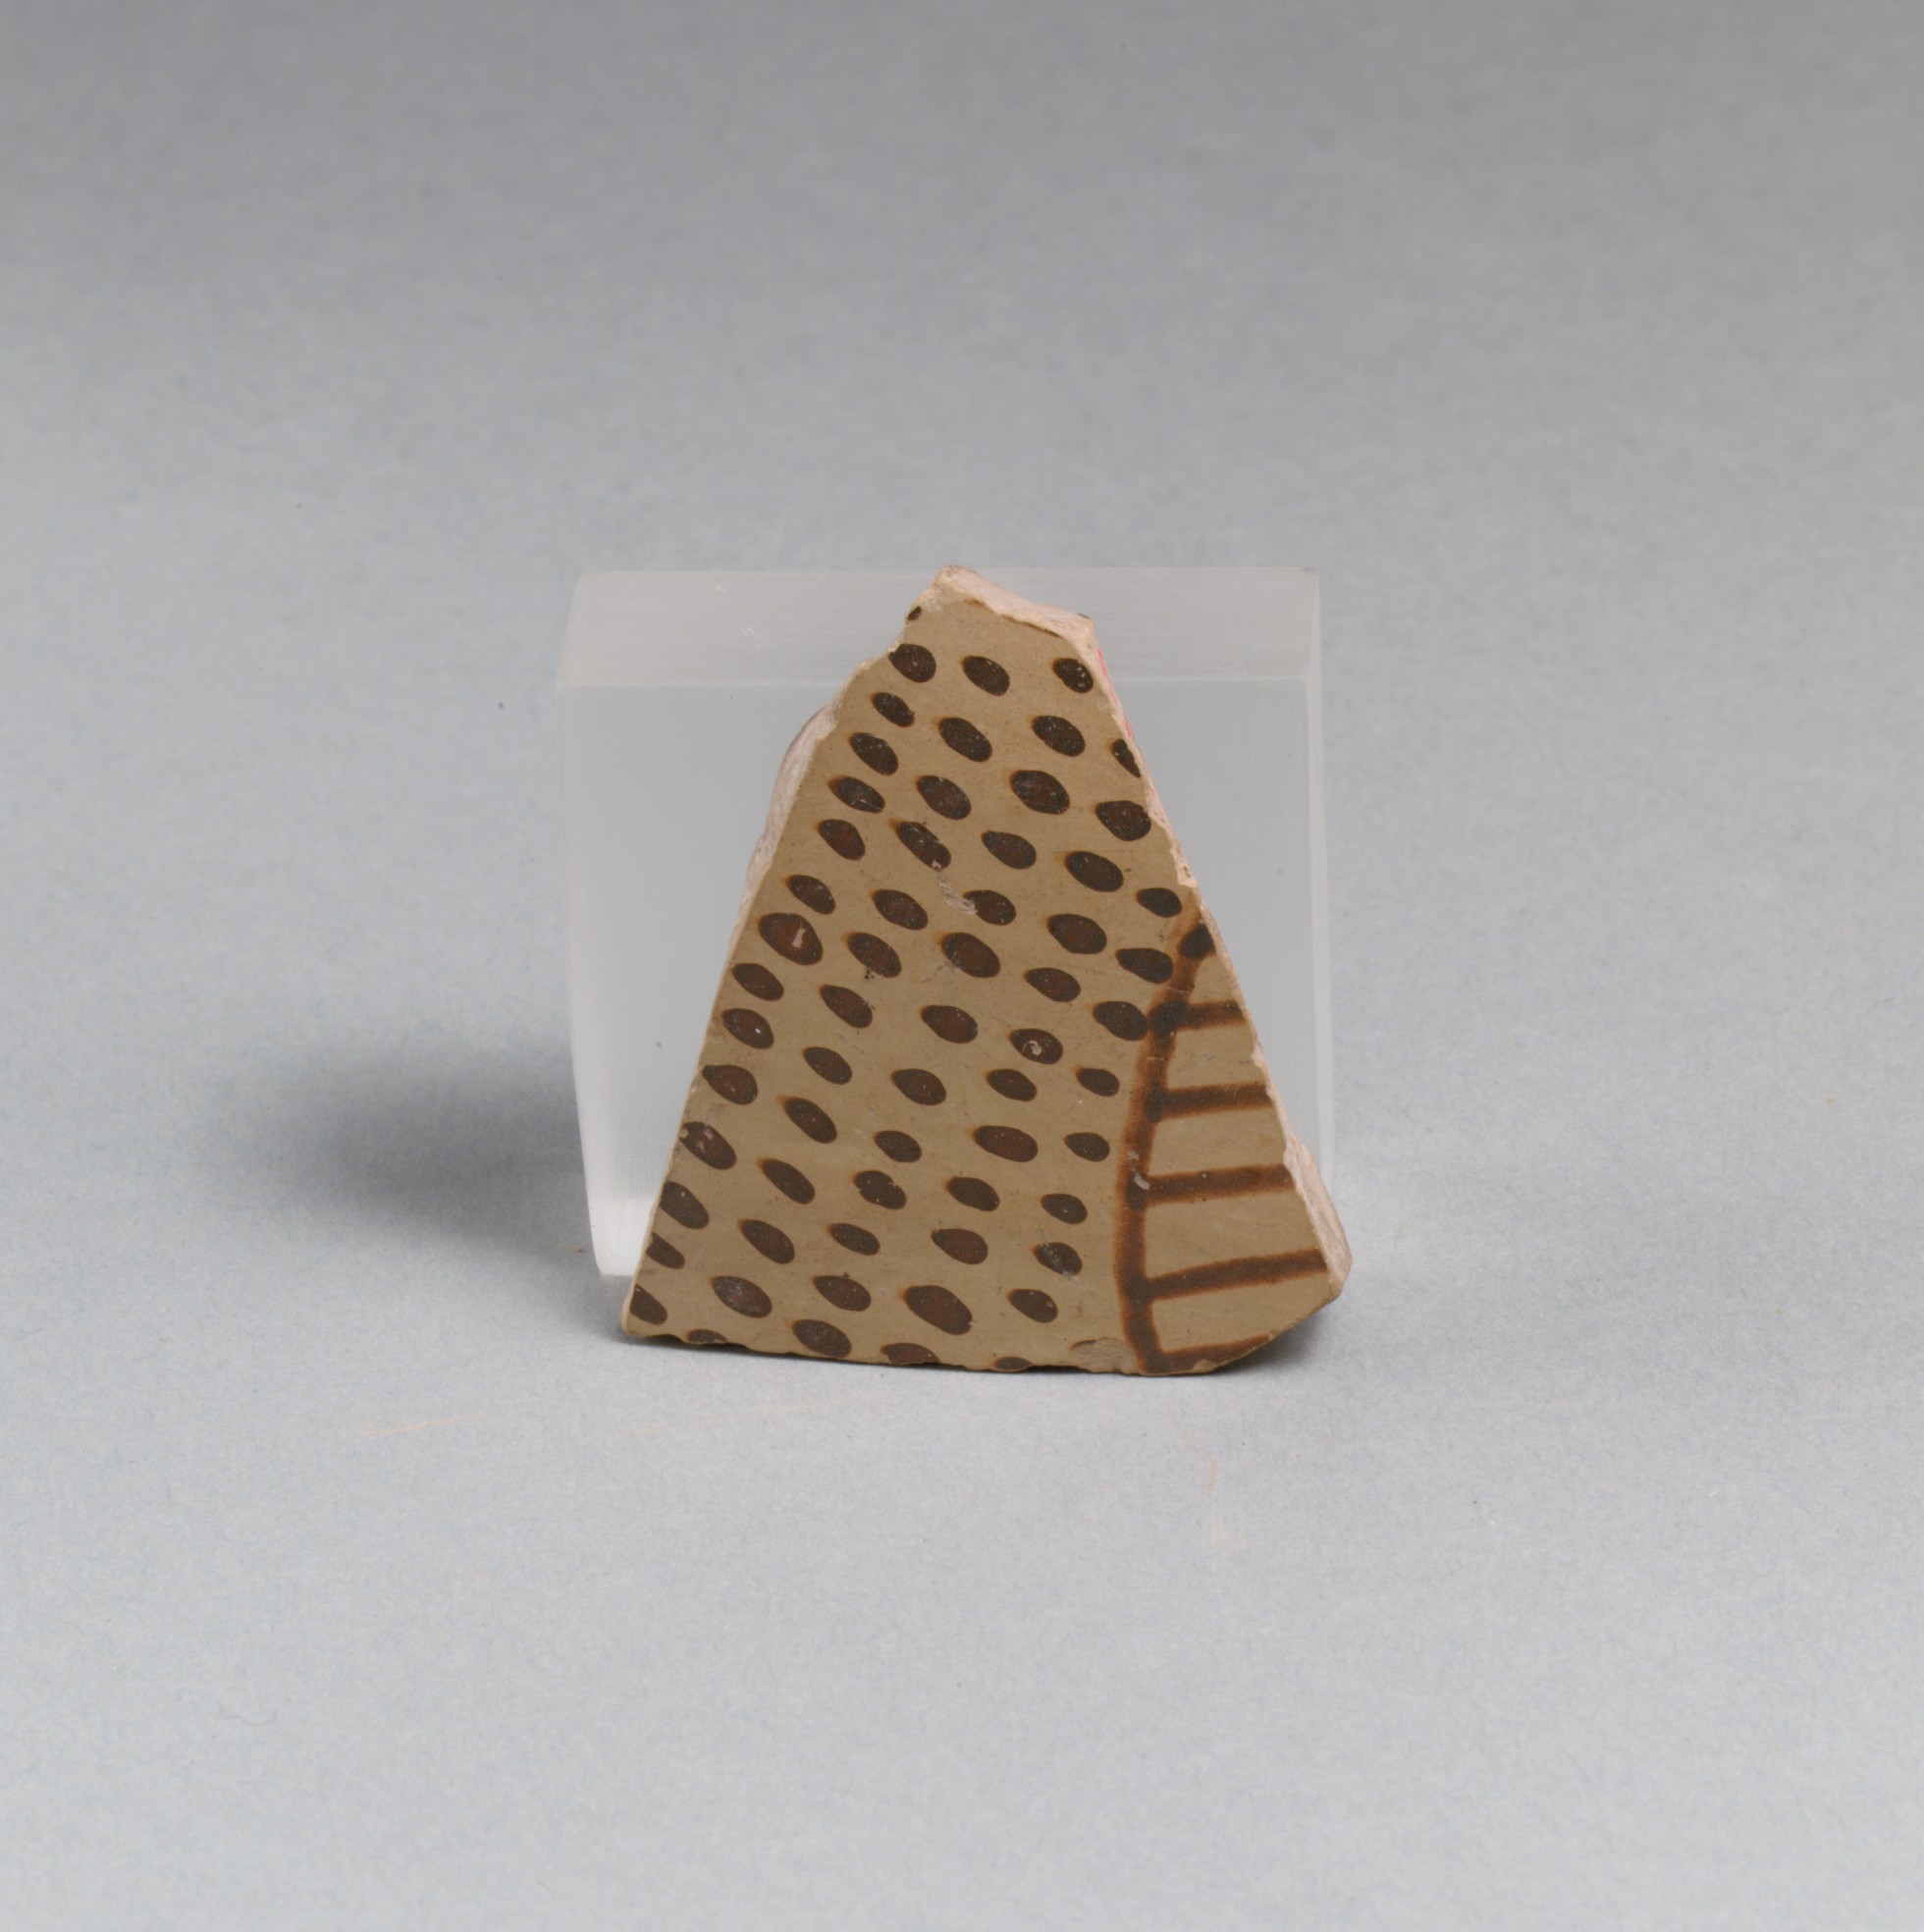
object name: vase fragment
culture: minoan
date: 1400-1200 BCE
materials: terracotta